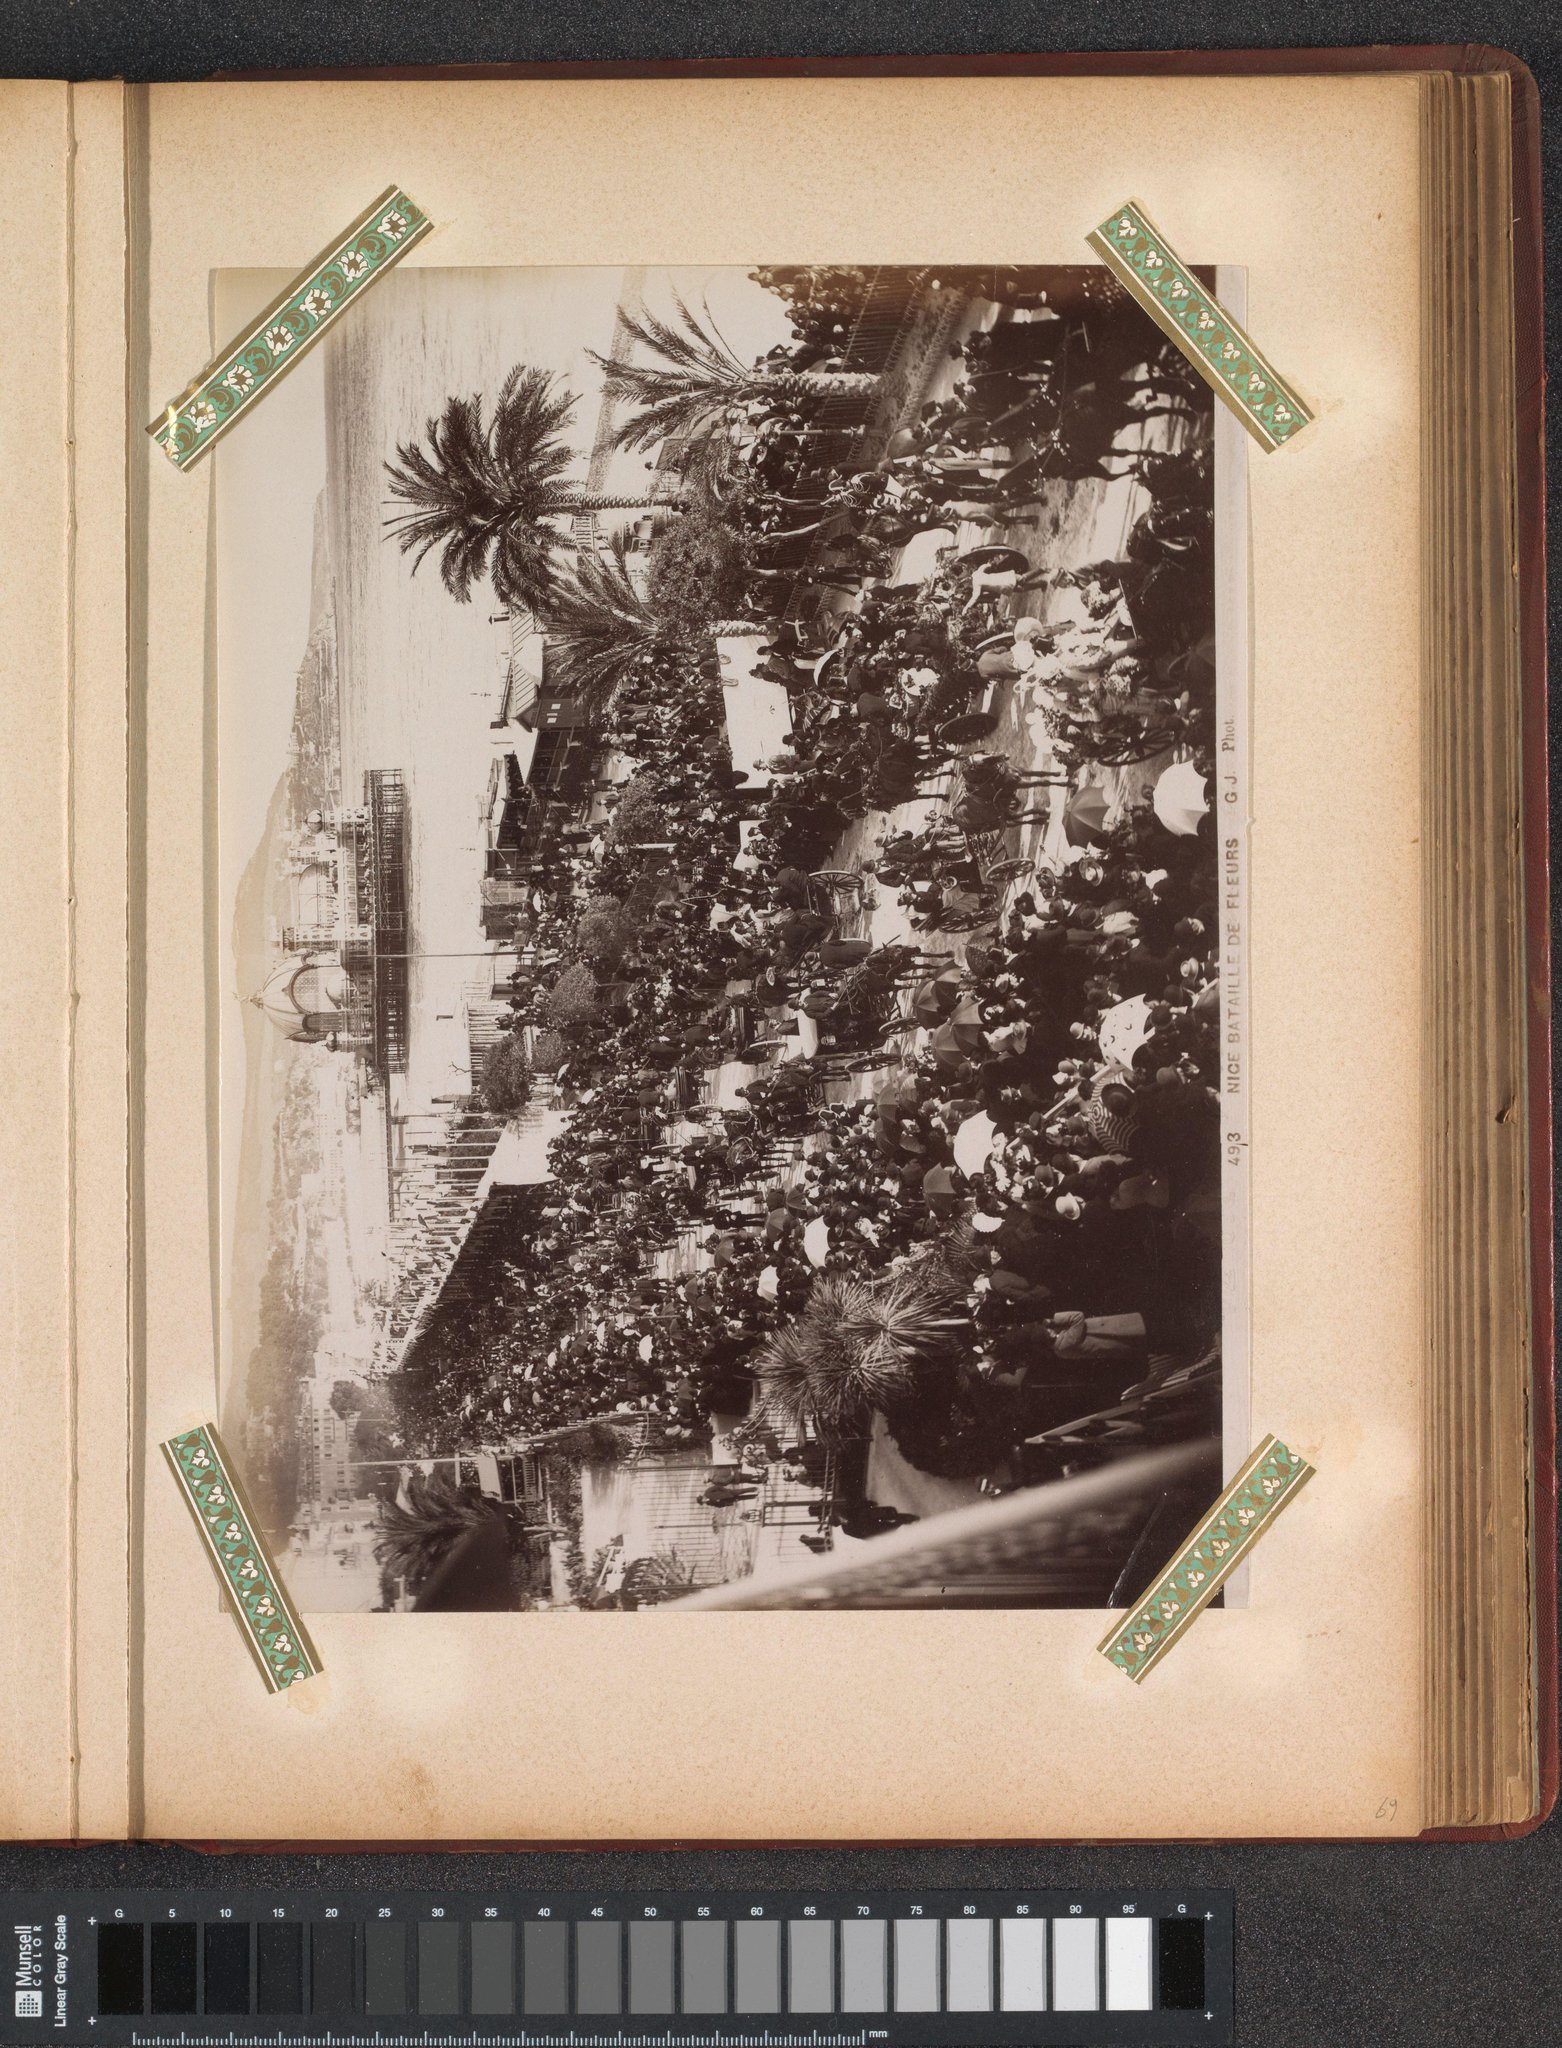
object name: photograph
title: Optocht met publiek tijdens Bataille de Fleurs in Nice, op de achtergrond een pier met gebouwen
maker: jean gilletta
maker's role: fotograaf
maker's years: 1856-1933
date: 1876-1900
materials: paper, photographic support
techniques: albumen print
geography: nice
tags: avenue, boulevard, promenade, esplanade (+ city(-scape) with figures, staffage), festivities (+ parade, pageant, cavalcade ~ festive activities), pier, quay, wharf, trees: palm-tree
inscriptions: negative number: ‘493’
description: Onderdeel van Reisalbum met foto's van bezienswaardigheden in Italië en Zuid-Frankrijk.